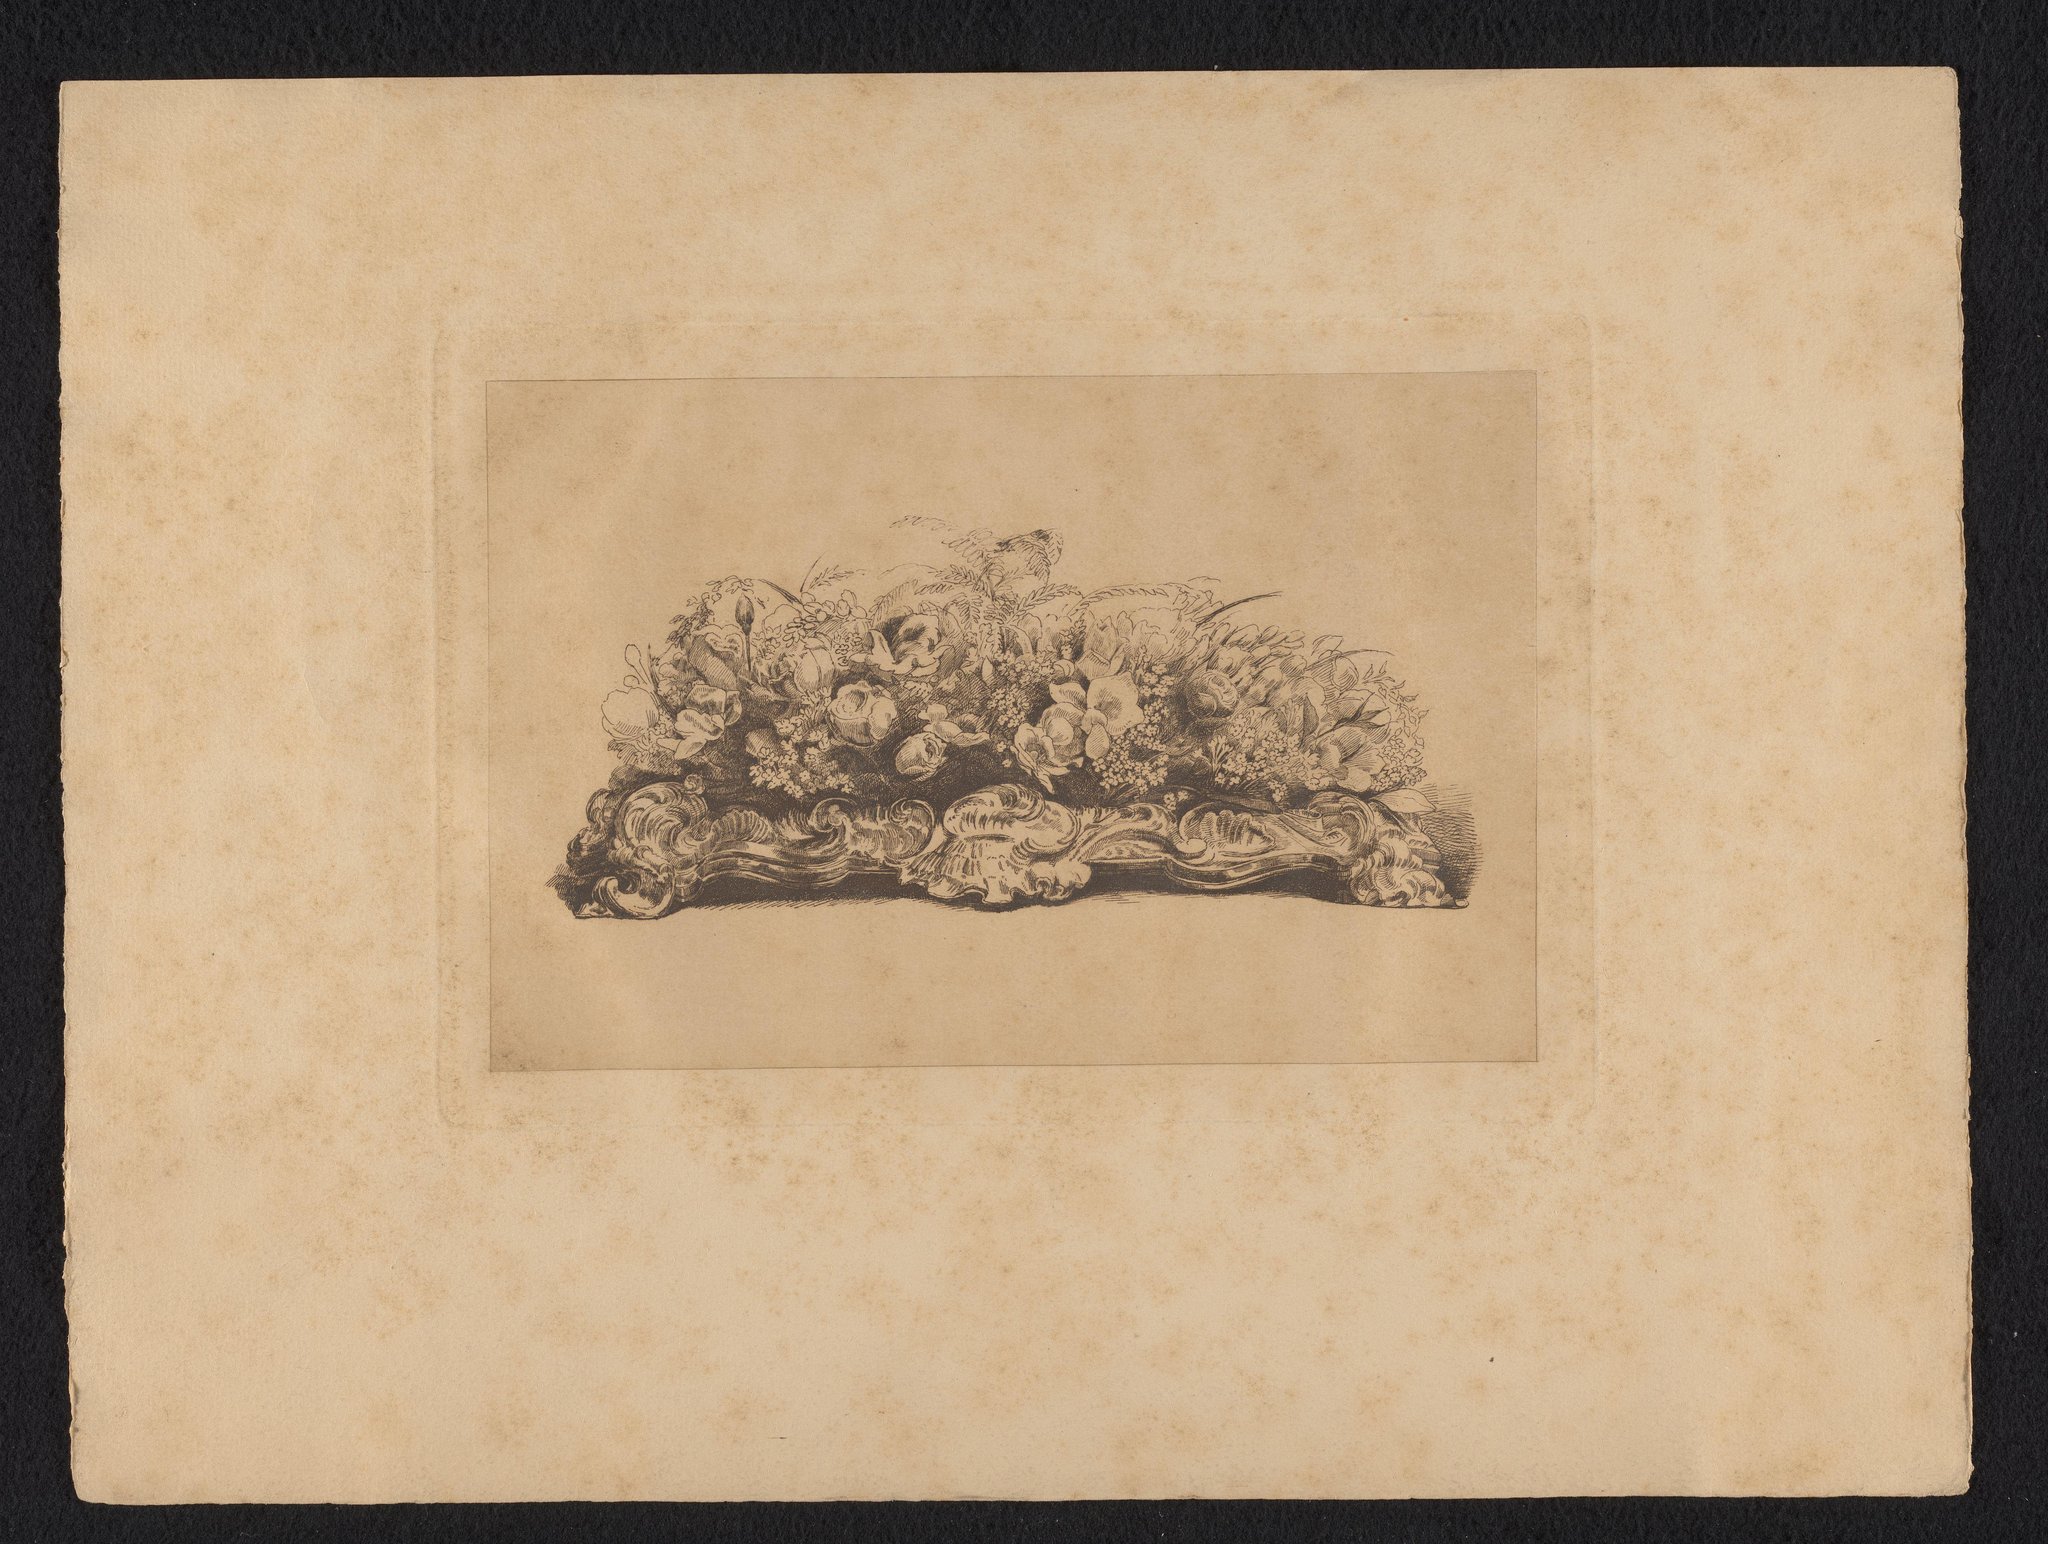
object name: print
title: Plateau ovale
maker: Anonymous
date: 1889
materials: paper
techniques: etching, intaglio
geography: utrecht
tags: serving-dish, platter, cut flowers; nosegay, bunch of flowers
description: Prent maakt deel uit van een serie van veertien prenten.